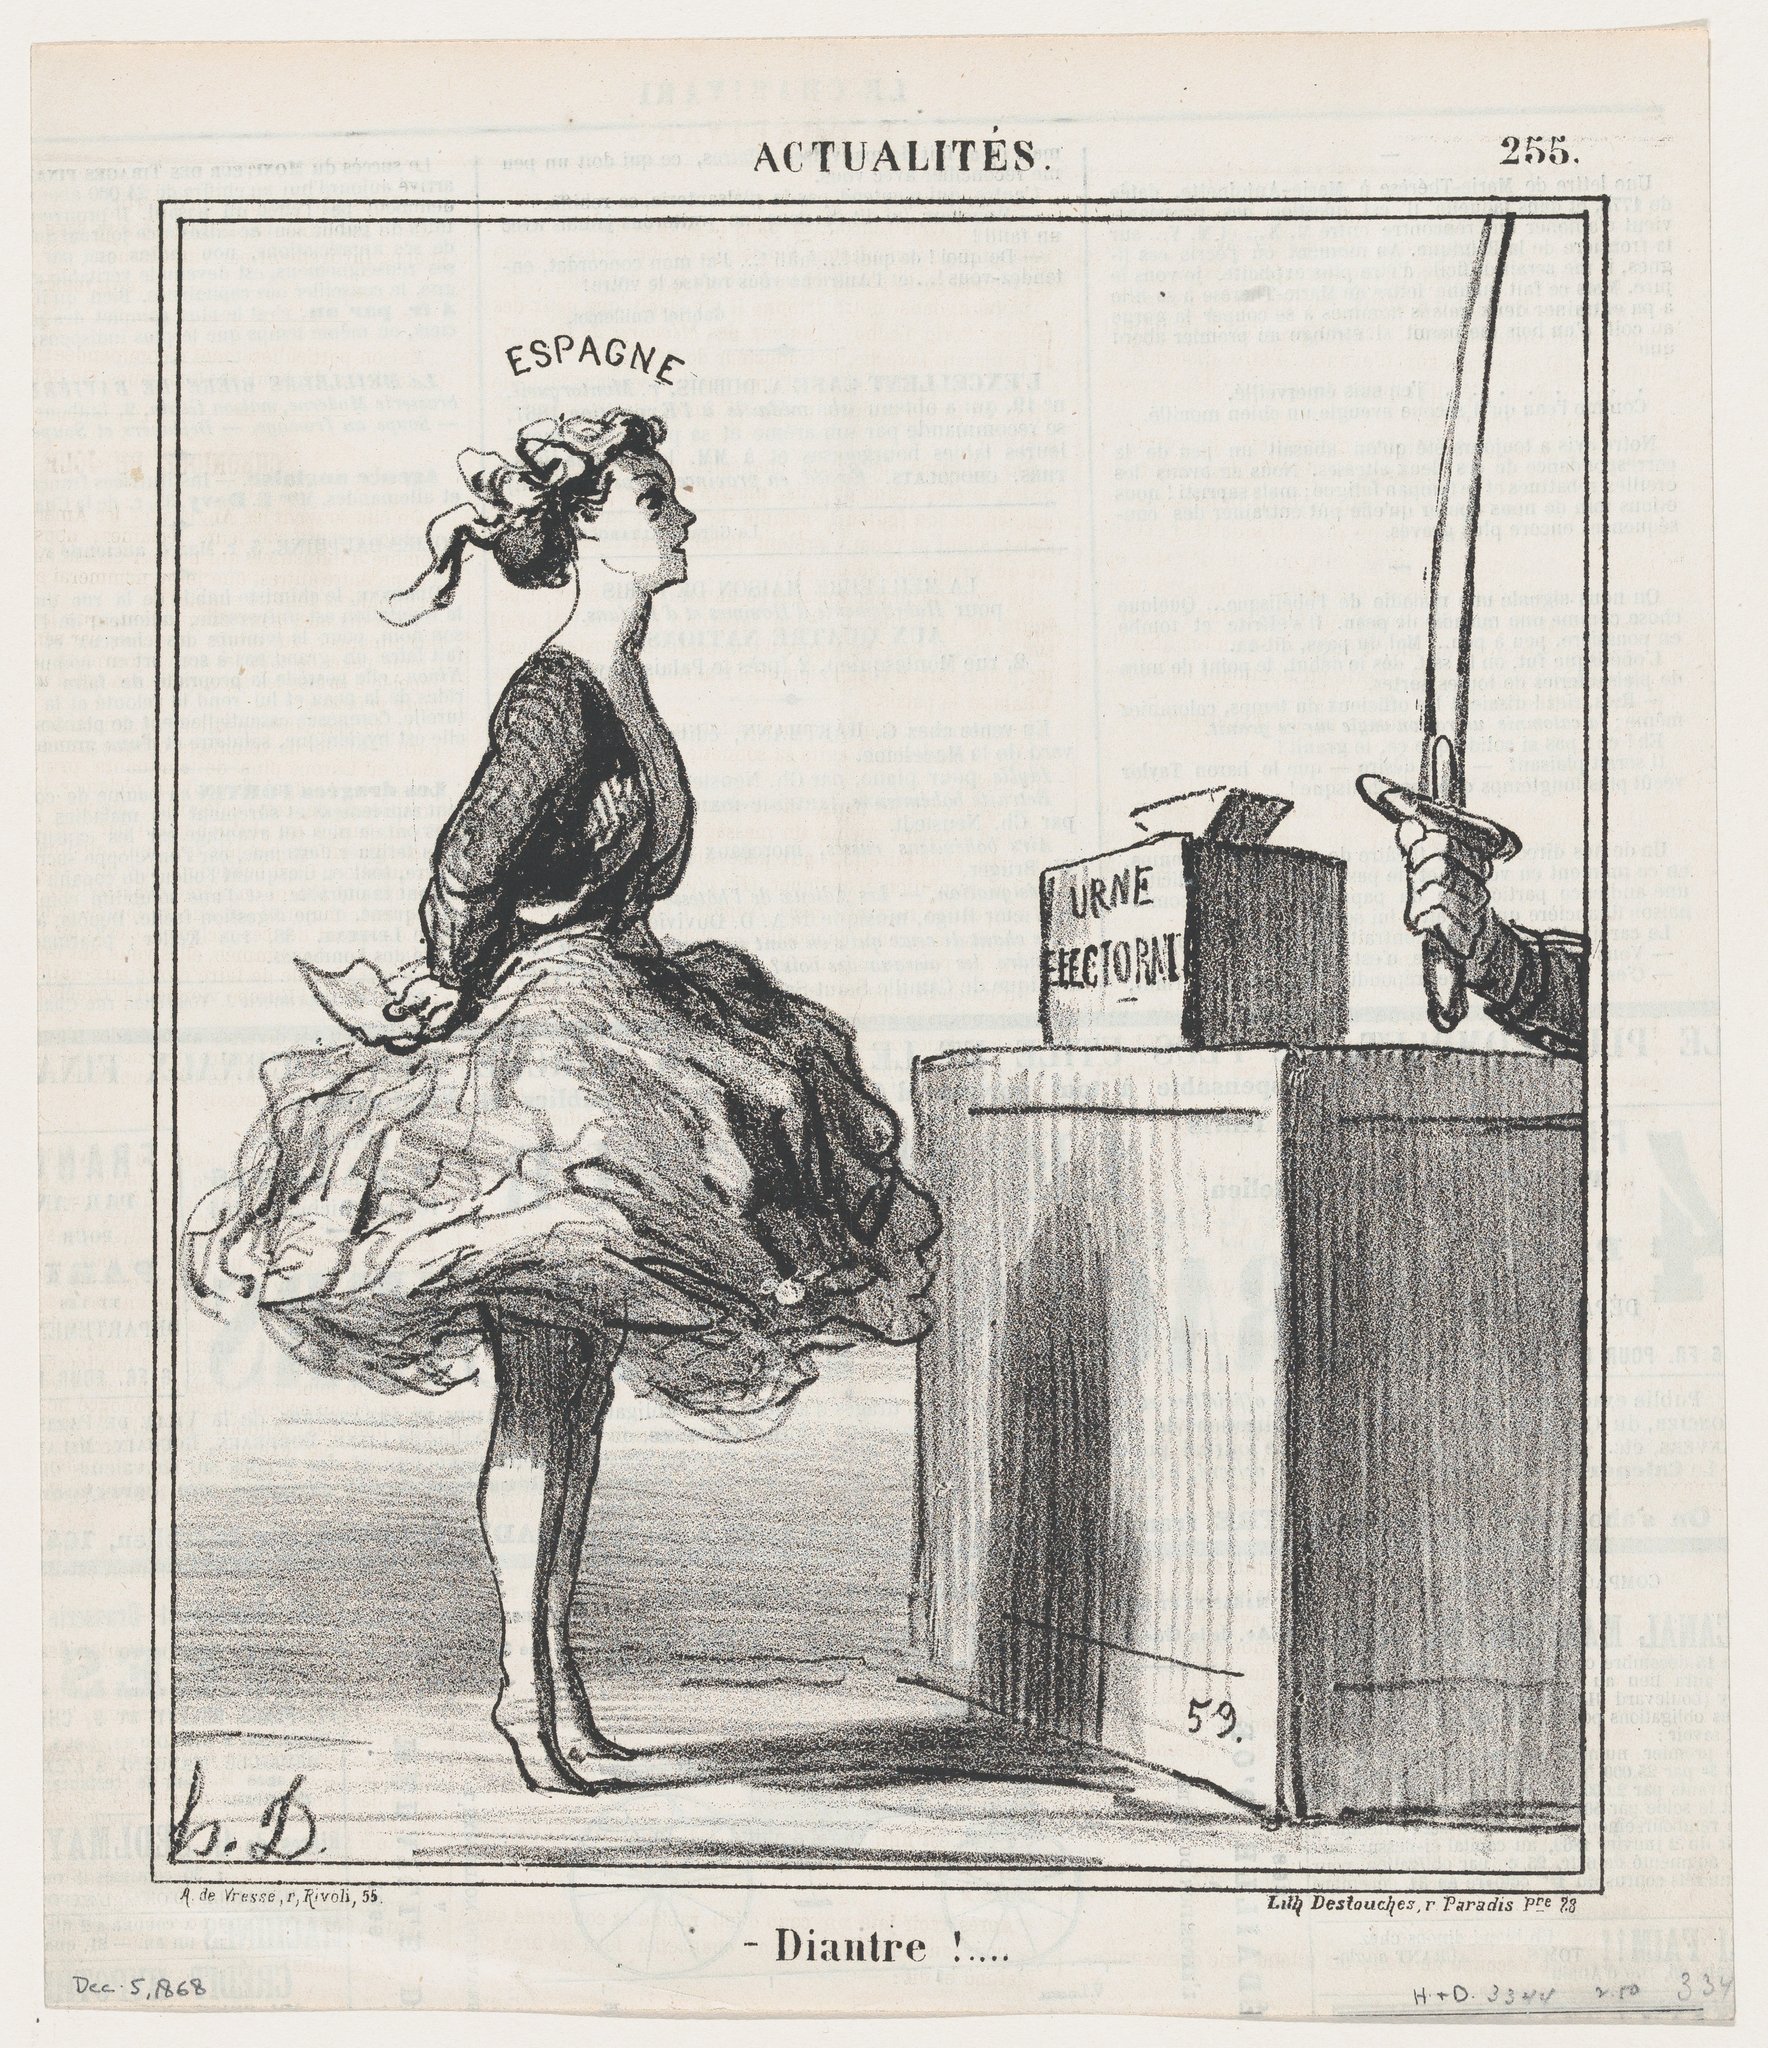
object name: print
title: Damnation!..., from "News of the Day"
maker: honoré daumier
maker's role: artist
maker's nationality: french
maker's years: 1808-1879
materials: paper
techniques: lithograph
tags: swords,women